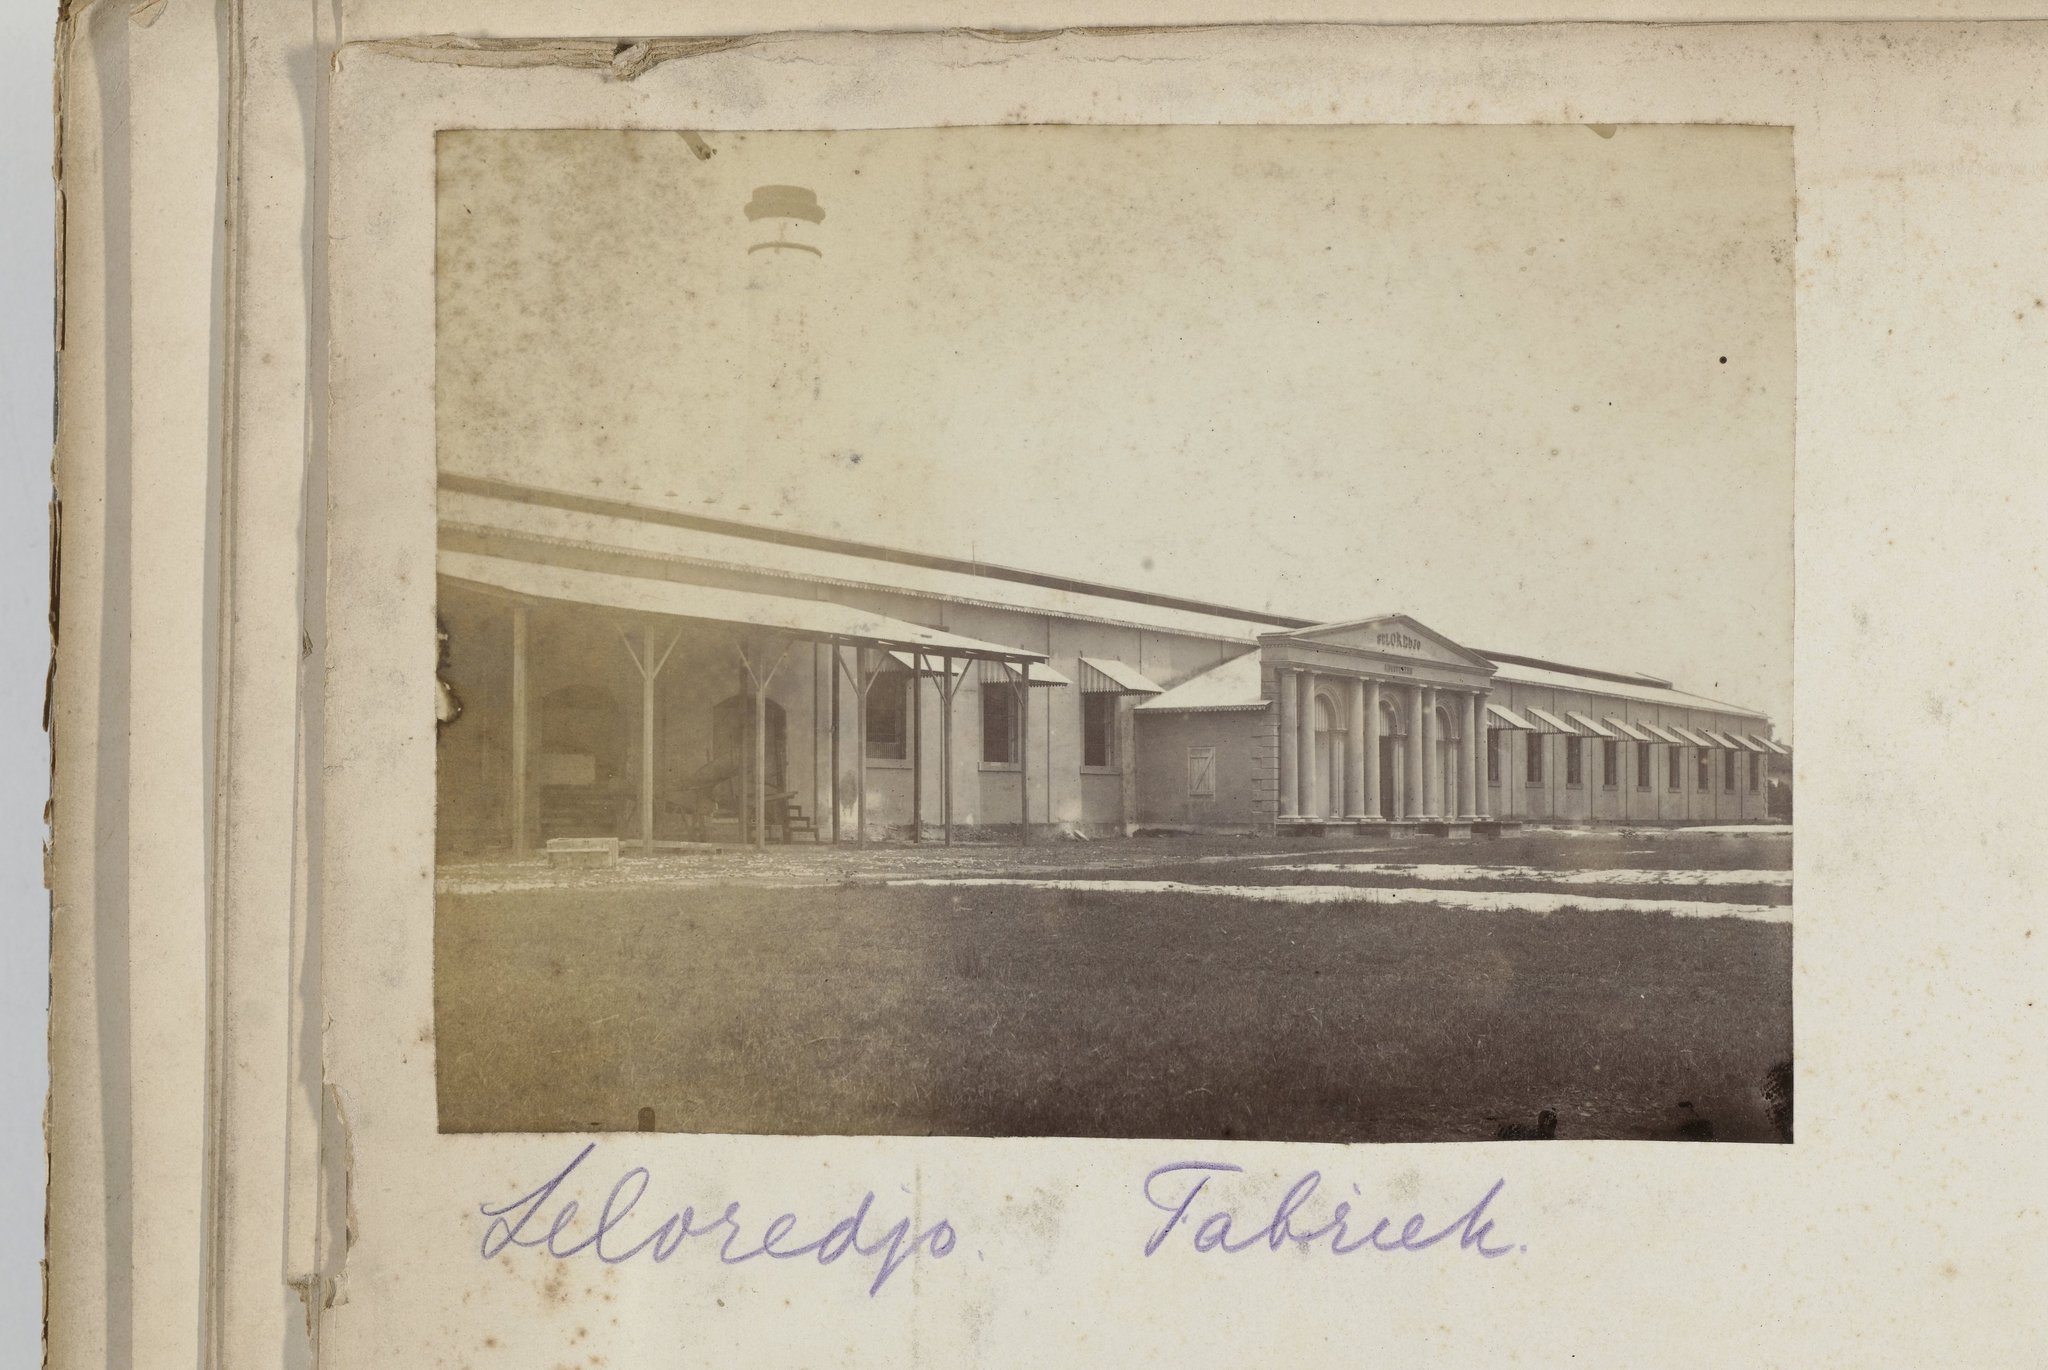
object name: photograph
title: Seloredjo Fabriek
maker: Anonymous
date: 1890-1910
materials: cardboard, paper, photographic support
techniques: gelatin silver print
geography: surabaya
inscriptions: caption: ‘Seloredjo fabriek’